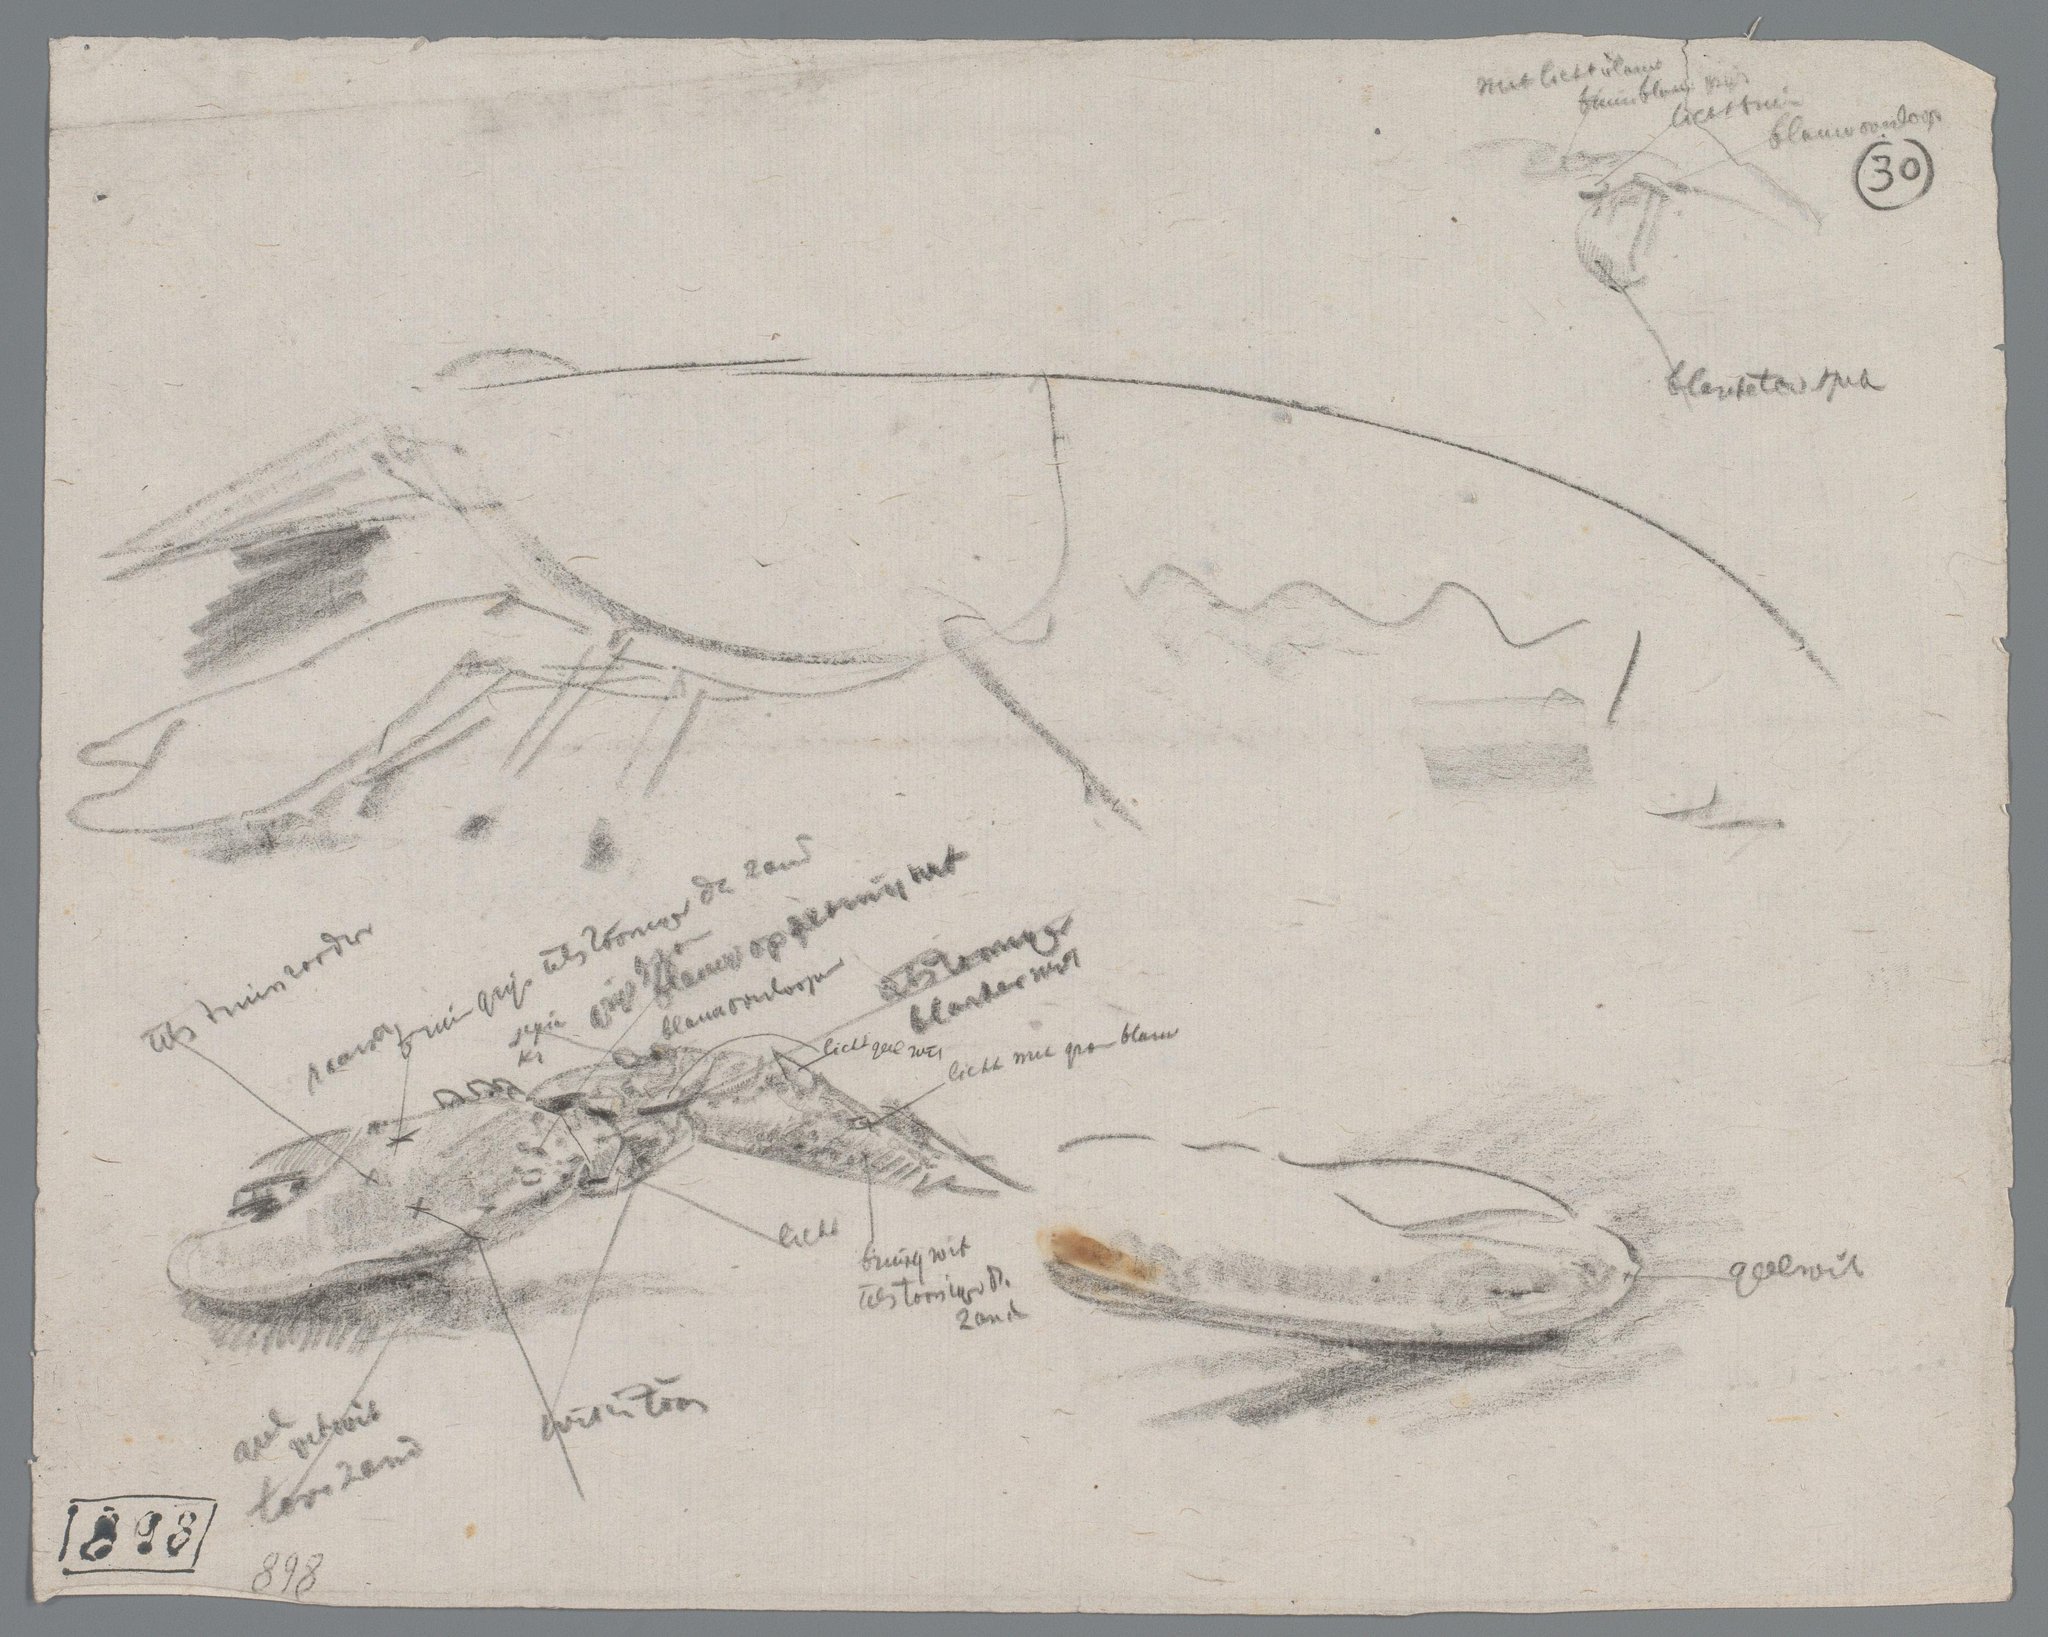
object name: drawing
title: Studie van een kreeft en de scharen van een kreeft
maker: gerrit willem dijsselhof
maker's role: designer, draughtsman, print maker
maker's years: 1866-1924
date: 1876-1924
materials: chalk, paper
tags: crustaceans: lobster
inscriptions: number: ‘898’, number: ‘30’